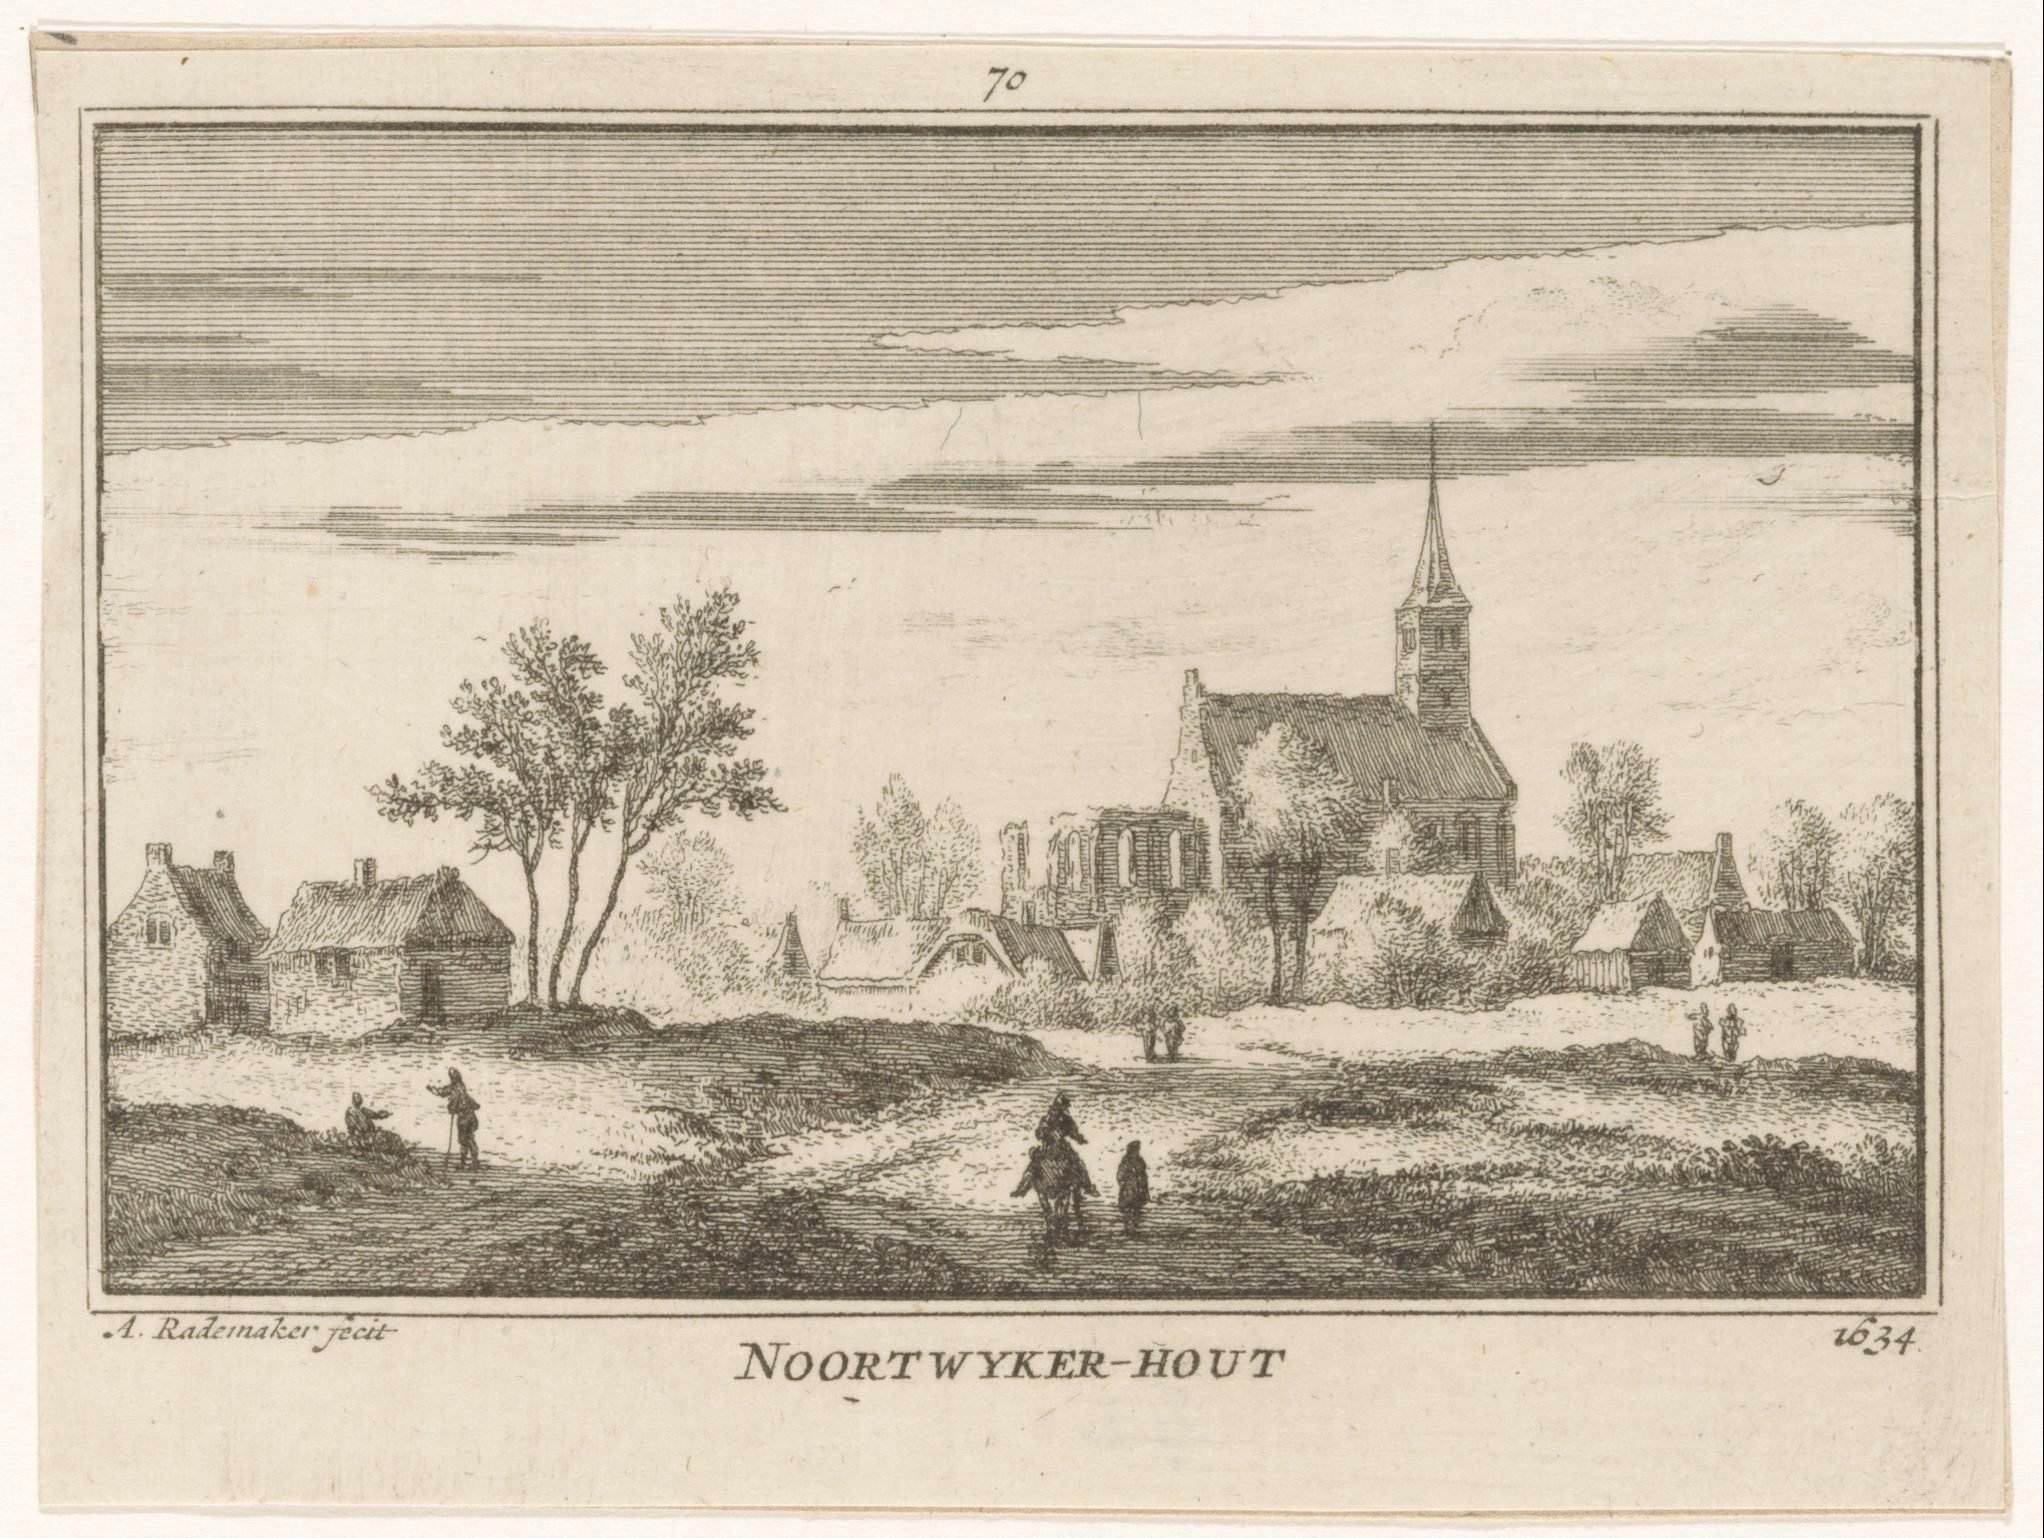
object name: book illustration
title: Gezicht op het Witte Kerkje te Noordwijkerhout, 1634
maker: abraham rademaker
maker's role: draughtsman, print maker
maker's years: 1676-1735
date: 1725-1803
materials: paper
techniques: engraving, etching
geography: amsterdam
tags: prospect of village, silhouette of village, church (exterior), ruin of church, monastery, etc., two-wheeled vehicle drawn by one animal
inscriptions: collector's mark: Lugt 2228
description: Prent ook gebruikt in: Rademaker, Abraham. Kabinet van Nederlandsche outheden en gezichten: vervat in 300 konstplaaten (…). 2 delen. Amsterdam: Willem Barents, 1725, dl. 1, ill. 70. Na 1725 is deze prent nog in verschillende heruitgaven verschenen, uitgegeven in 1727-1733, 1770-1771 en 1792-1803. Uit welke uitgave het huidige exemplaar precies komt is niet na te gaan.